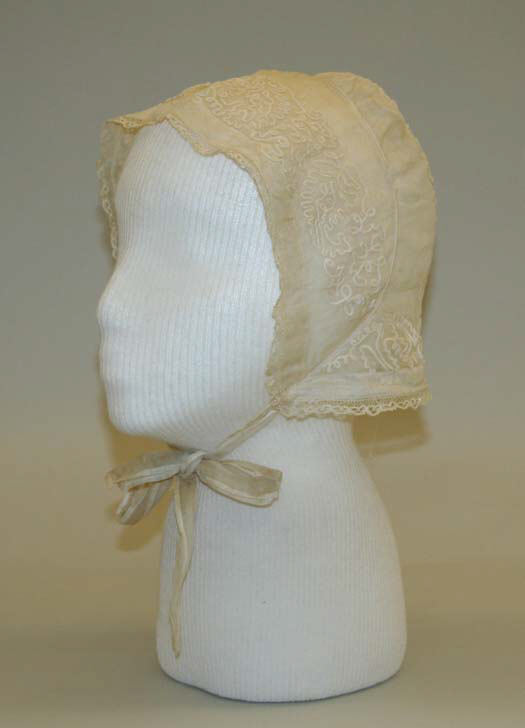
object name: cap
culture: american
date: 1840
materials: cotton